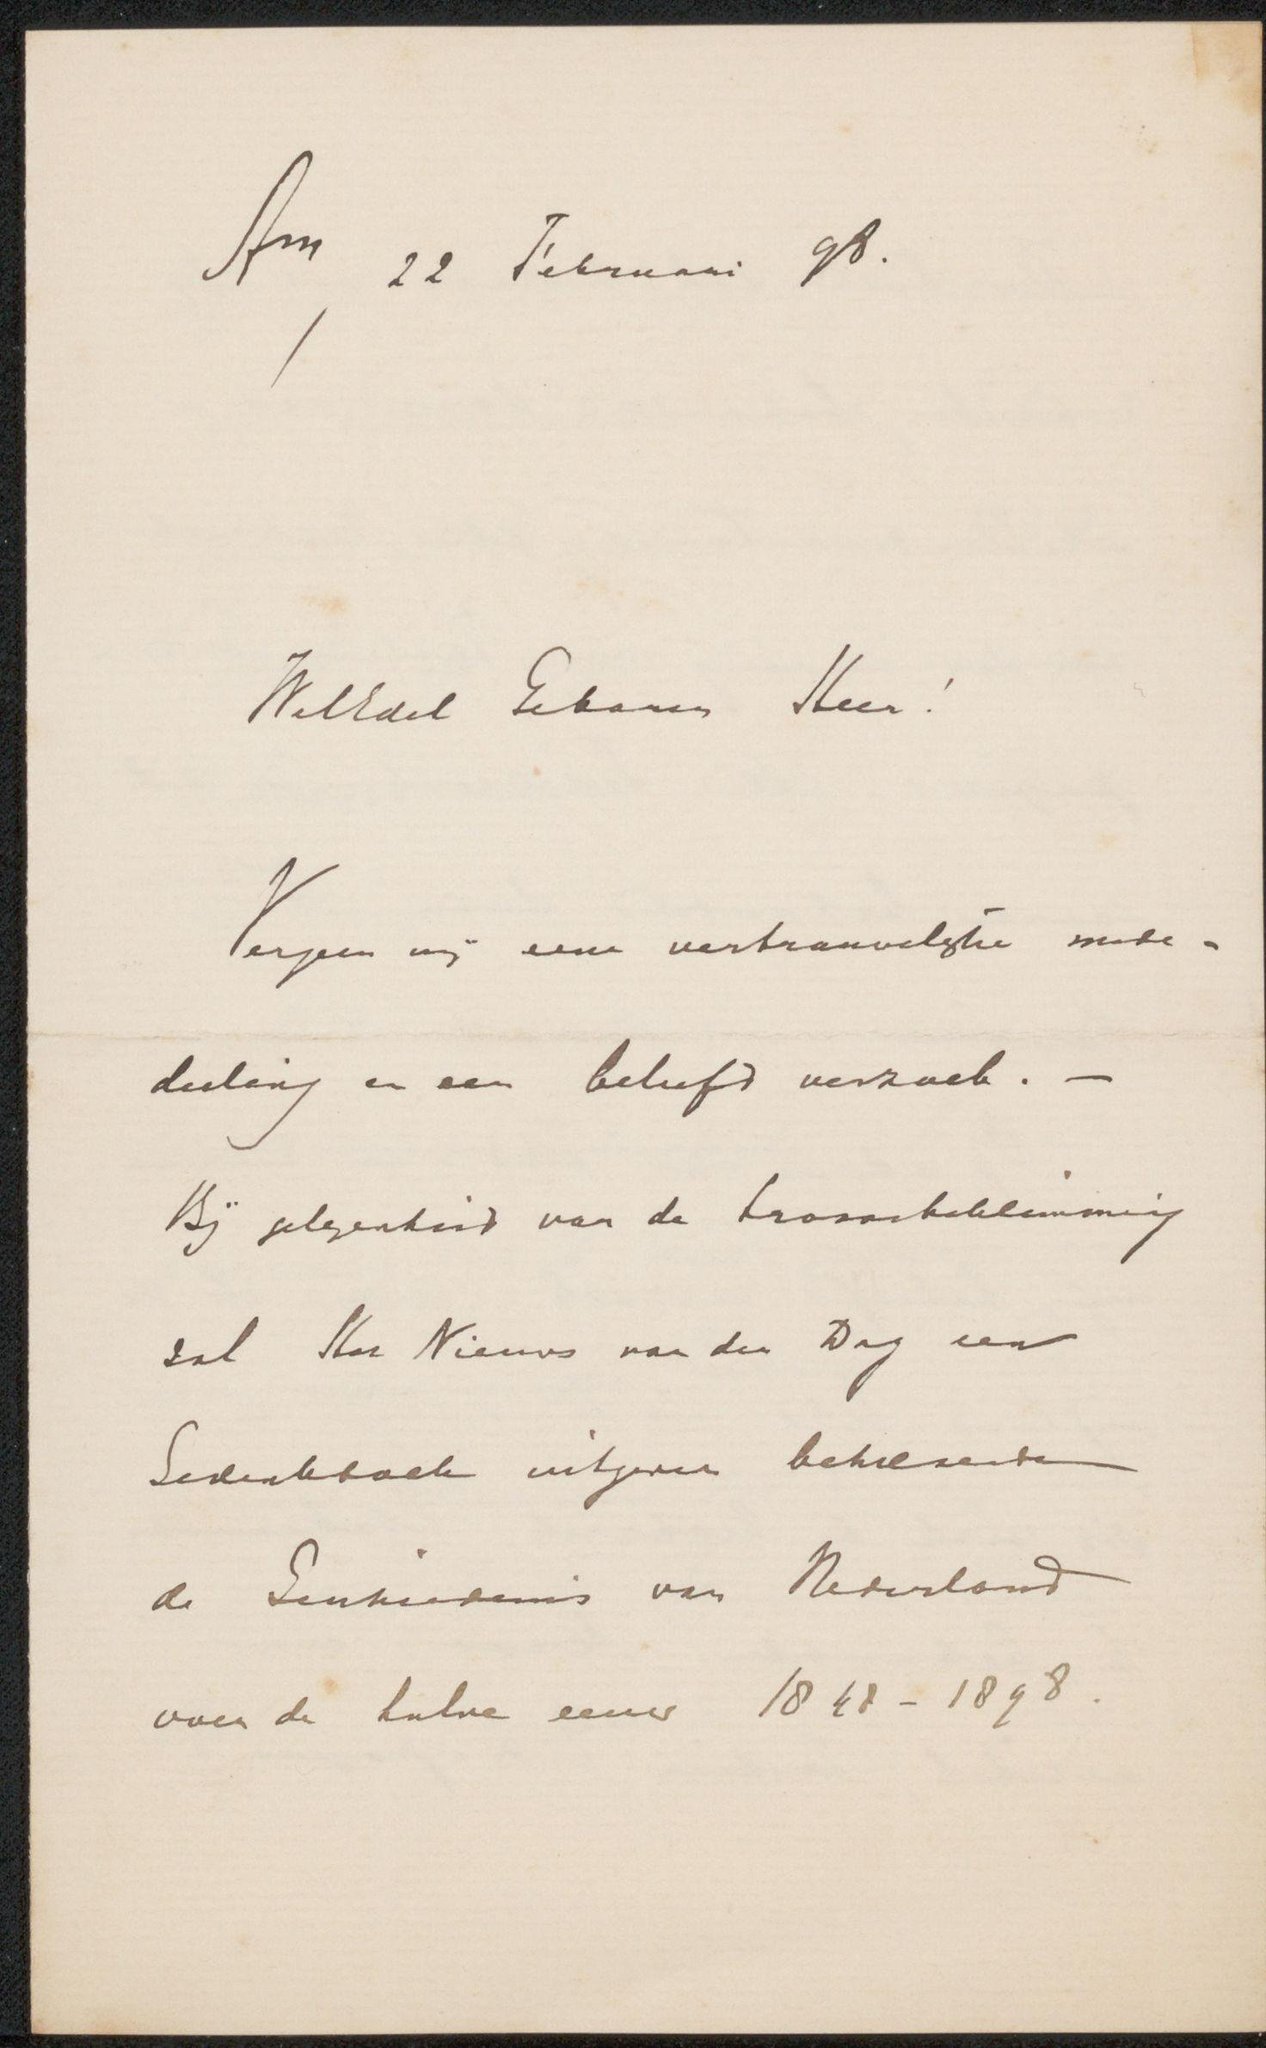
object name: letter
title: Brief aan Philip Zilcken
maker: pierre henri ritter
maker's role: dominee, hoofdredacteur, hoogleraar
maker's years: 1851-1912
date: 1898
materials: ink, paper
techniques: pen, writing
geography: amsterdam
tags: amsterdam, abraham bredius, the hague, cornelis hofstede de groot, draughtsman, philip zilcken, the graphic arts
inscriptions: watermark, collector's mark: ‘RPK’